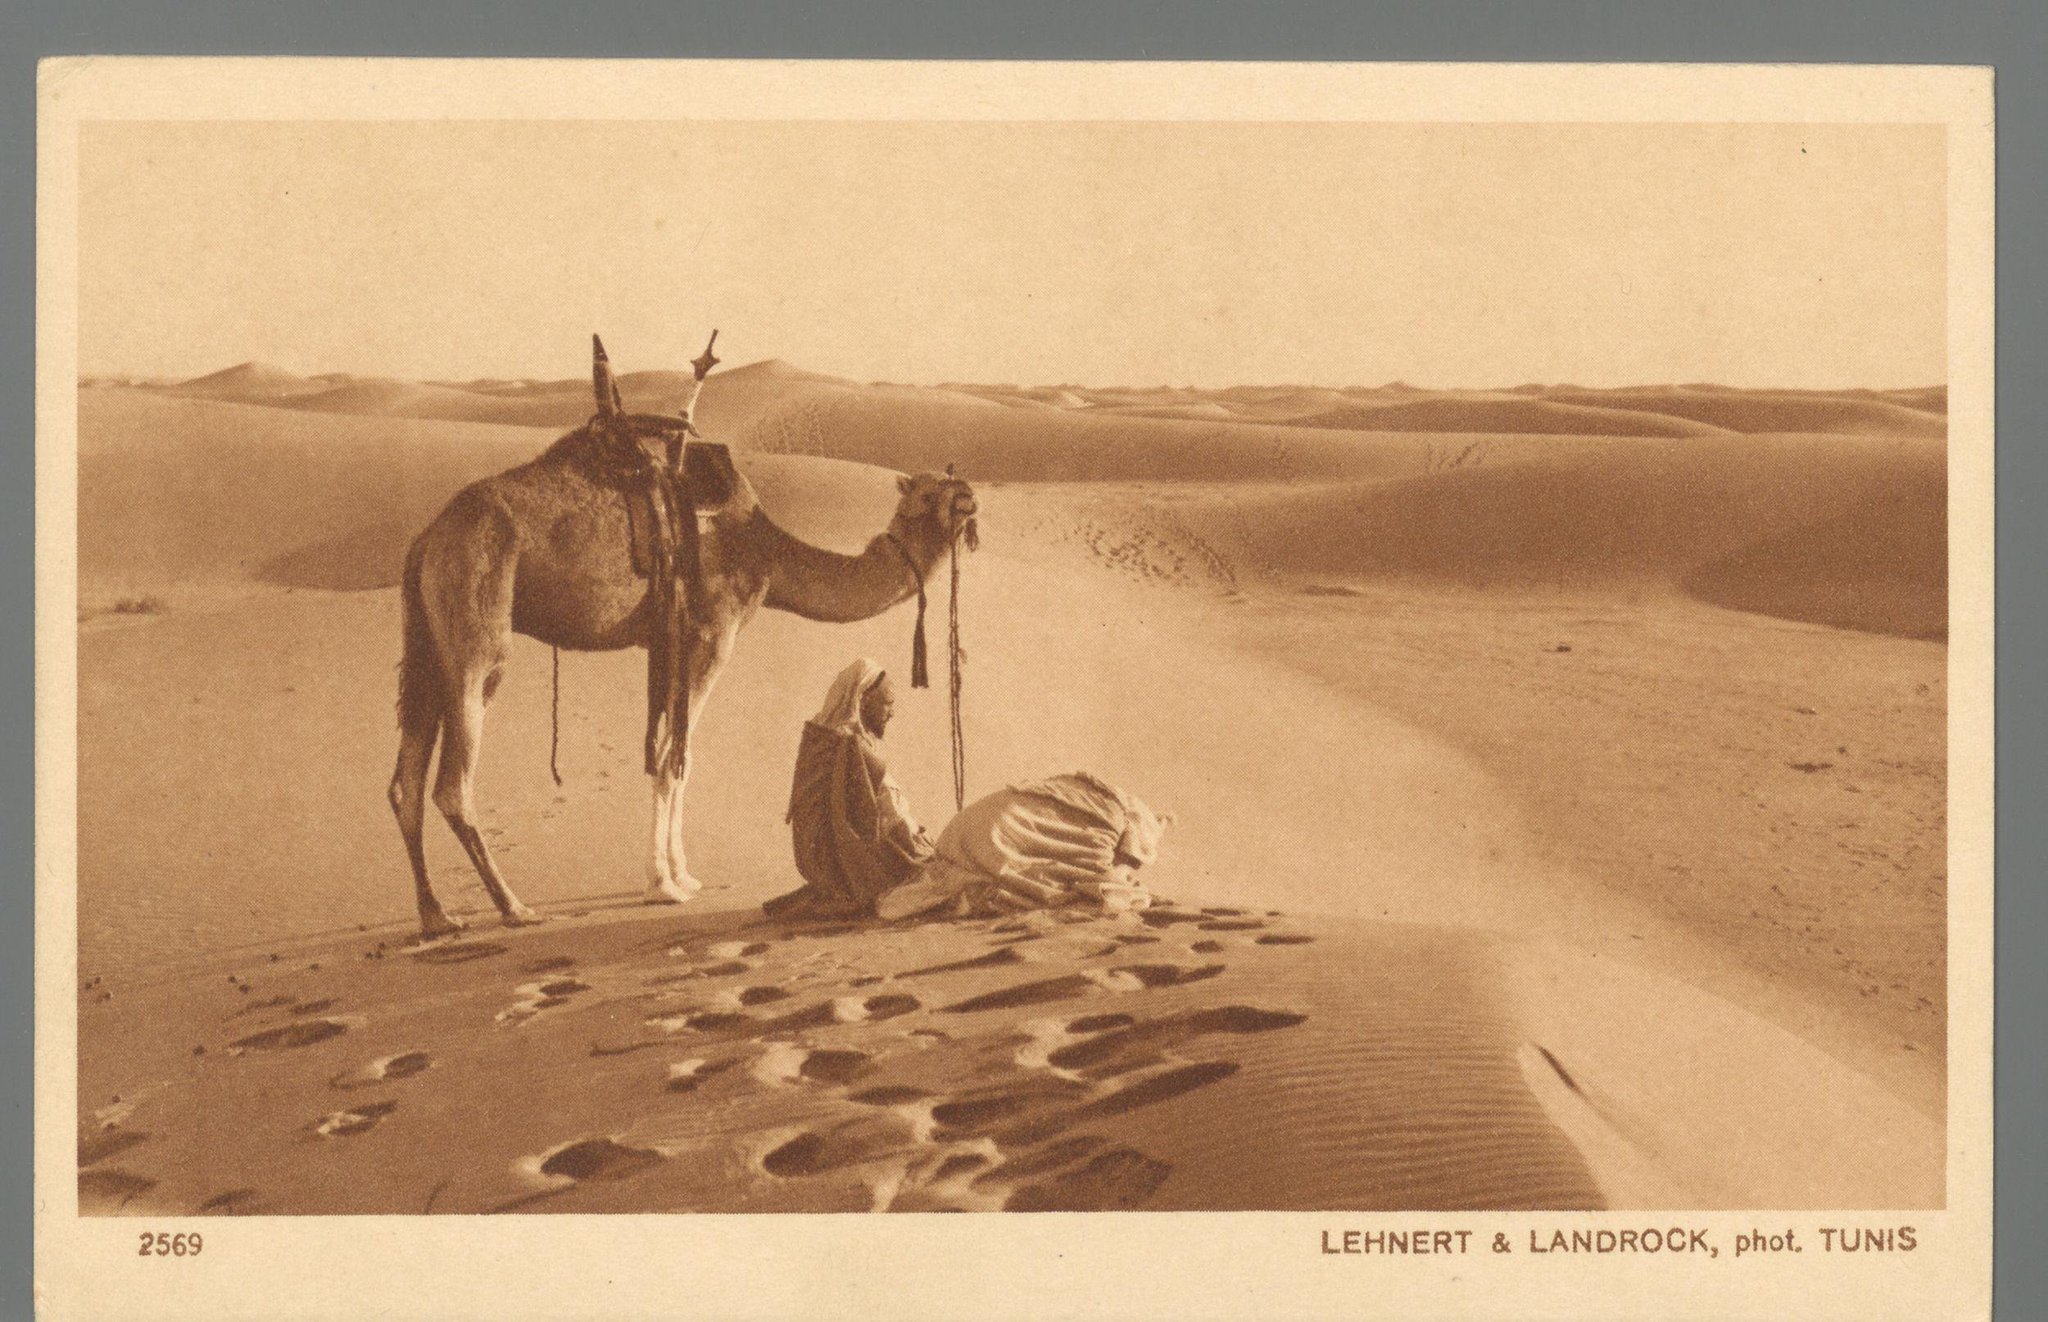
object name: photomechanical print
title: Paysages d'orient. Serie VI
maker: Anonymous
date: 1903-1930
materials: cardboard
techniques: rotogravure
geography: tunis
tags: hoofed animals: camel, desert, prayer ~ islam, mohammedanism